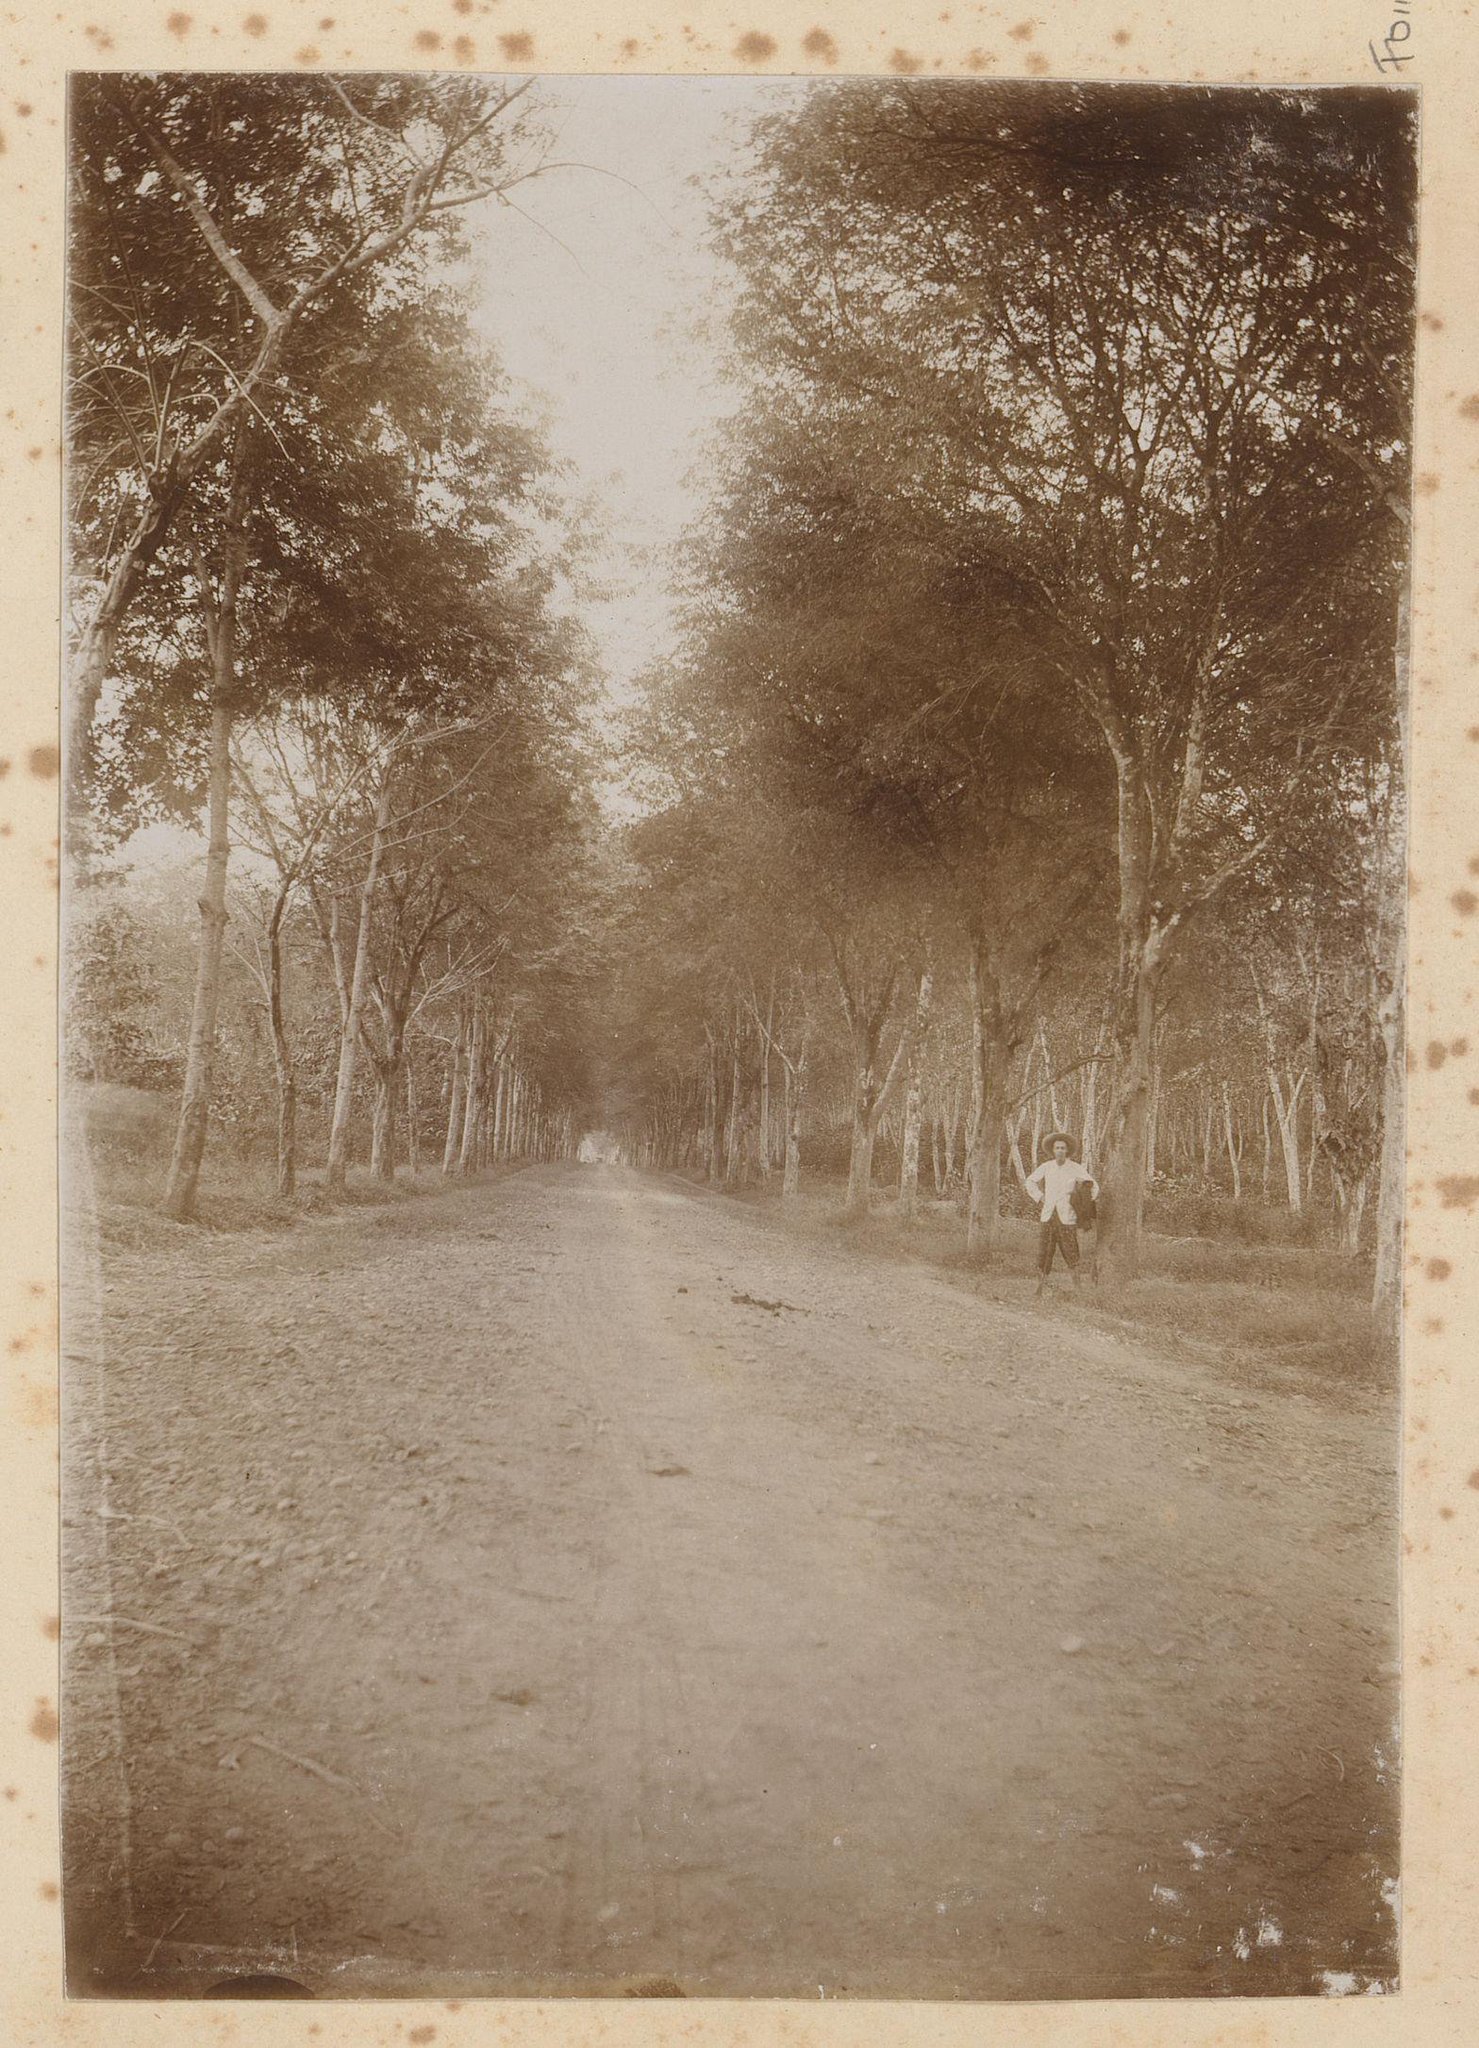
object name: album leaf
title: Nederlandse man langs een bospad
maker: Anonymous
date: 1890-1910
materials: photographic support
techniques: collodion silver print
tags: adult man, forest path or lane, europeans (with name), dutch east indies, the